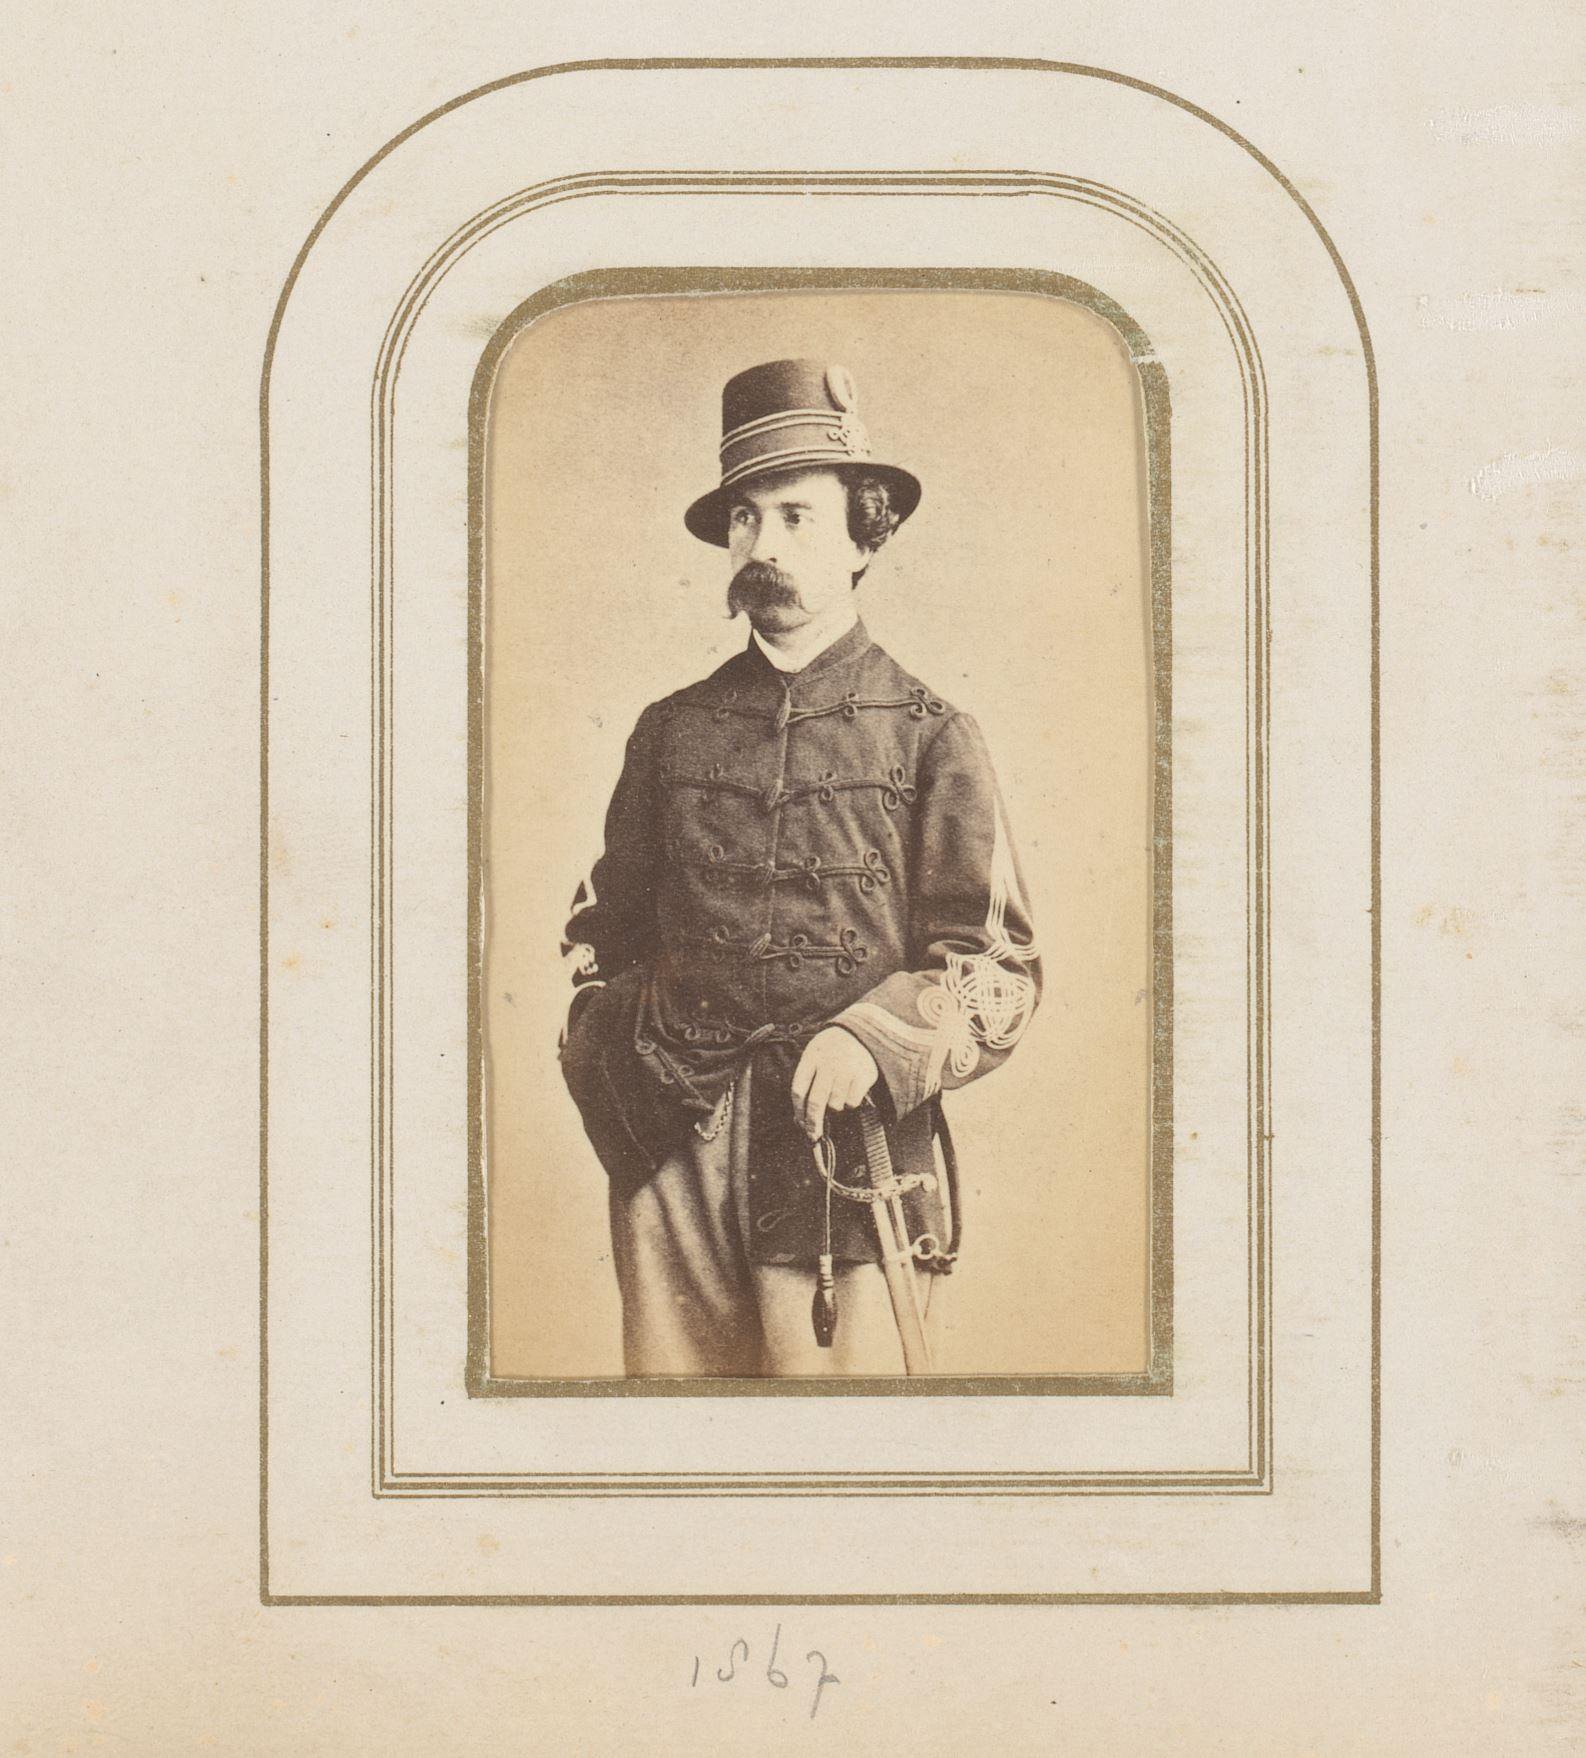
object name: carte de visite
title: Portret van een man in uniform met hoed en zwaard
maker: Anonymous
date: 1867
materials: cardboard, photographic support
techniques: albumen print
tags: historical persons, hacking and thrusting weapons: sword, head-gear: hat, (military) uniforms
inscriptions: date: ‘1867’, annotation: ‘Au Capitaine/ A. Lemoine/ témoignage [...]d'affection/ [...]/ 1867’